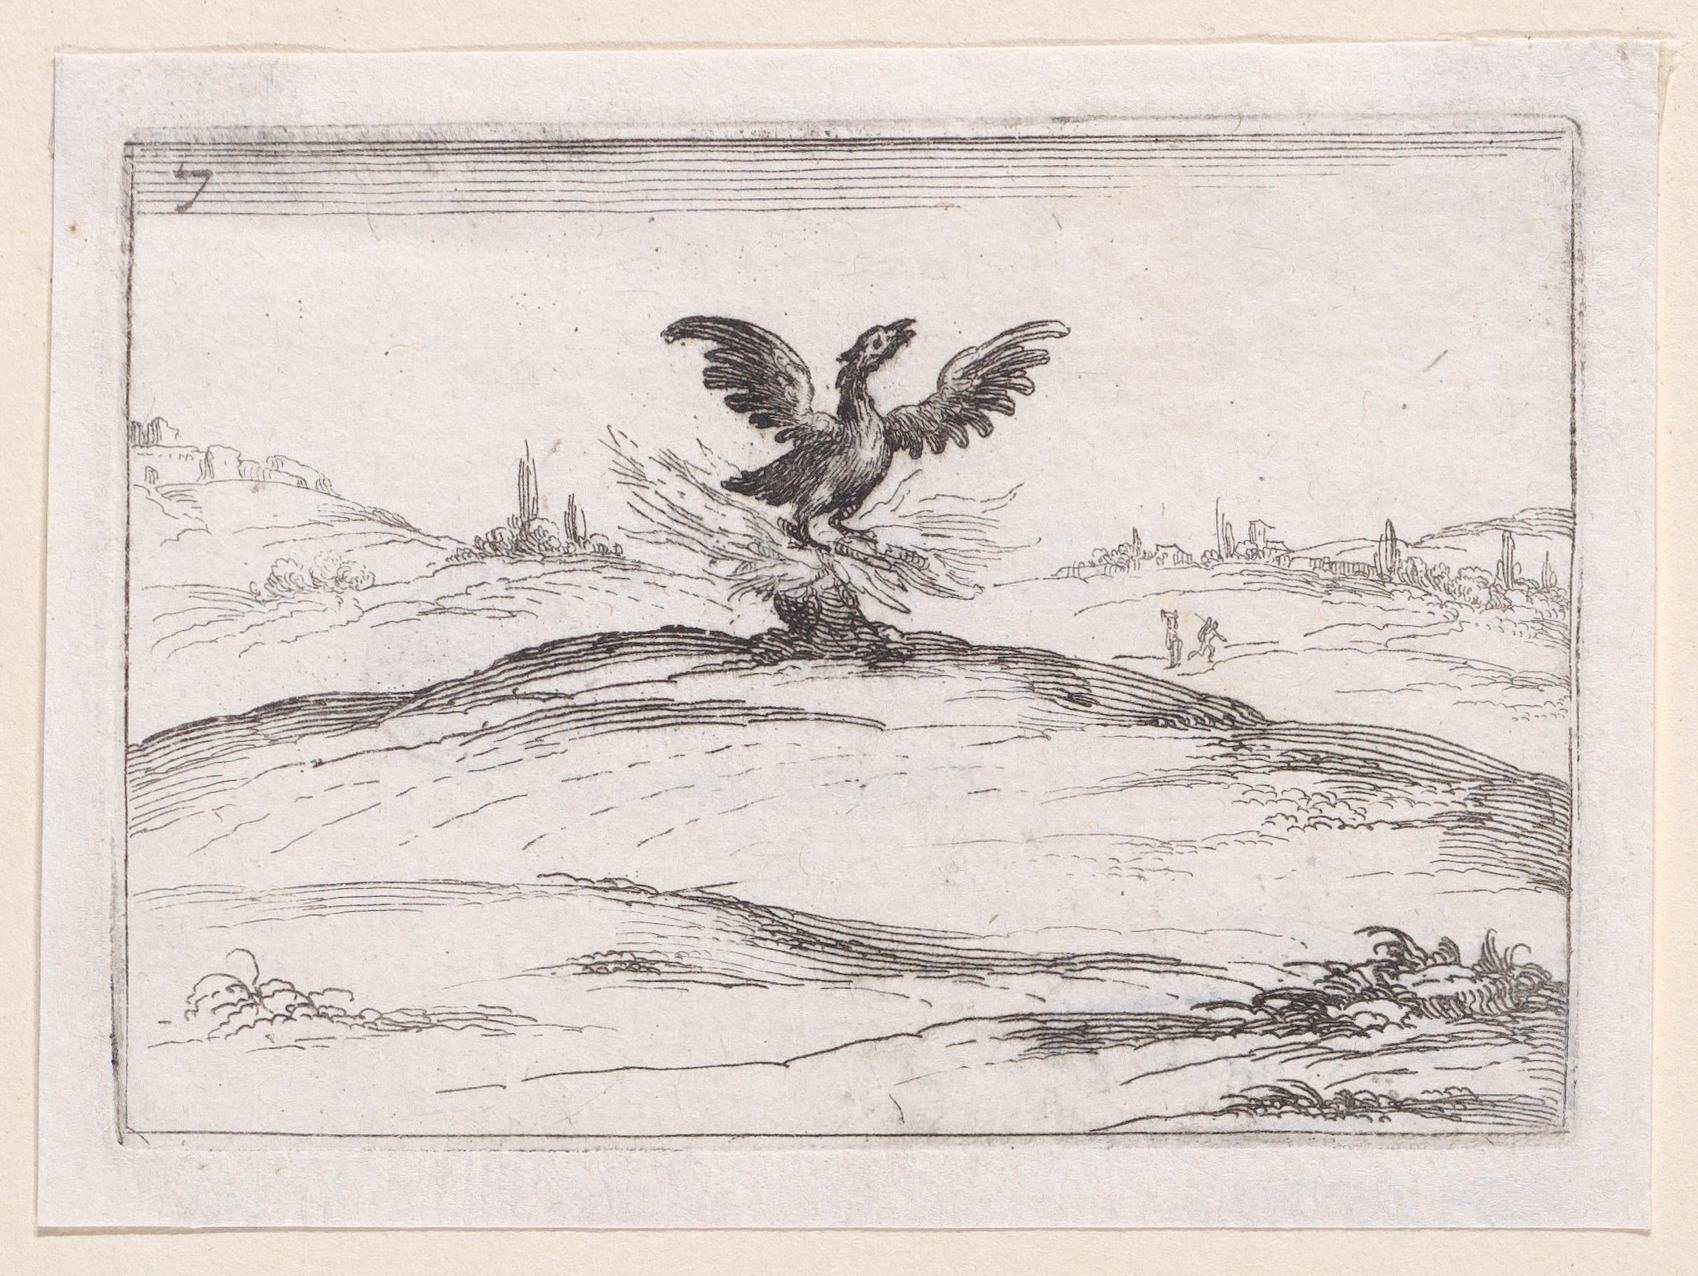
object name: print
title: Le Phénix se Brulant (The Phoenix is Burning), plate 7 from "Lux Claustri ou La Lumière du Cloitre" (The Light of the Cloisters)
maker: jacques callot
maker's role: artist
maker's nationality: french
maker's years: 1592-1635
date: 1621-1635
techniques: etching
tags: phoenix